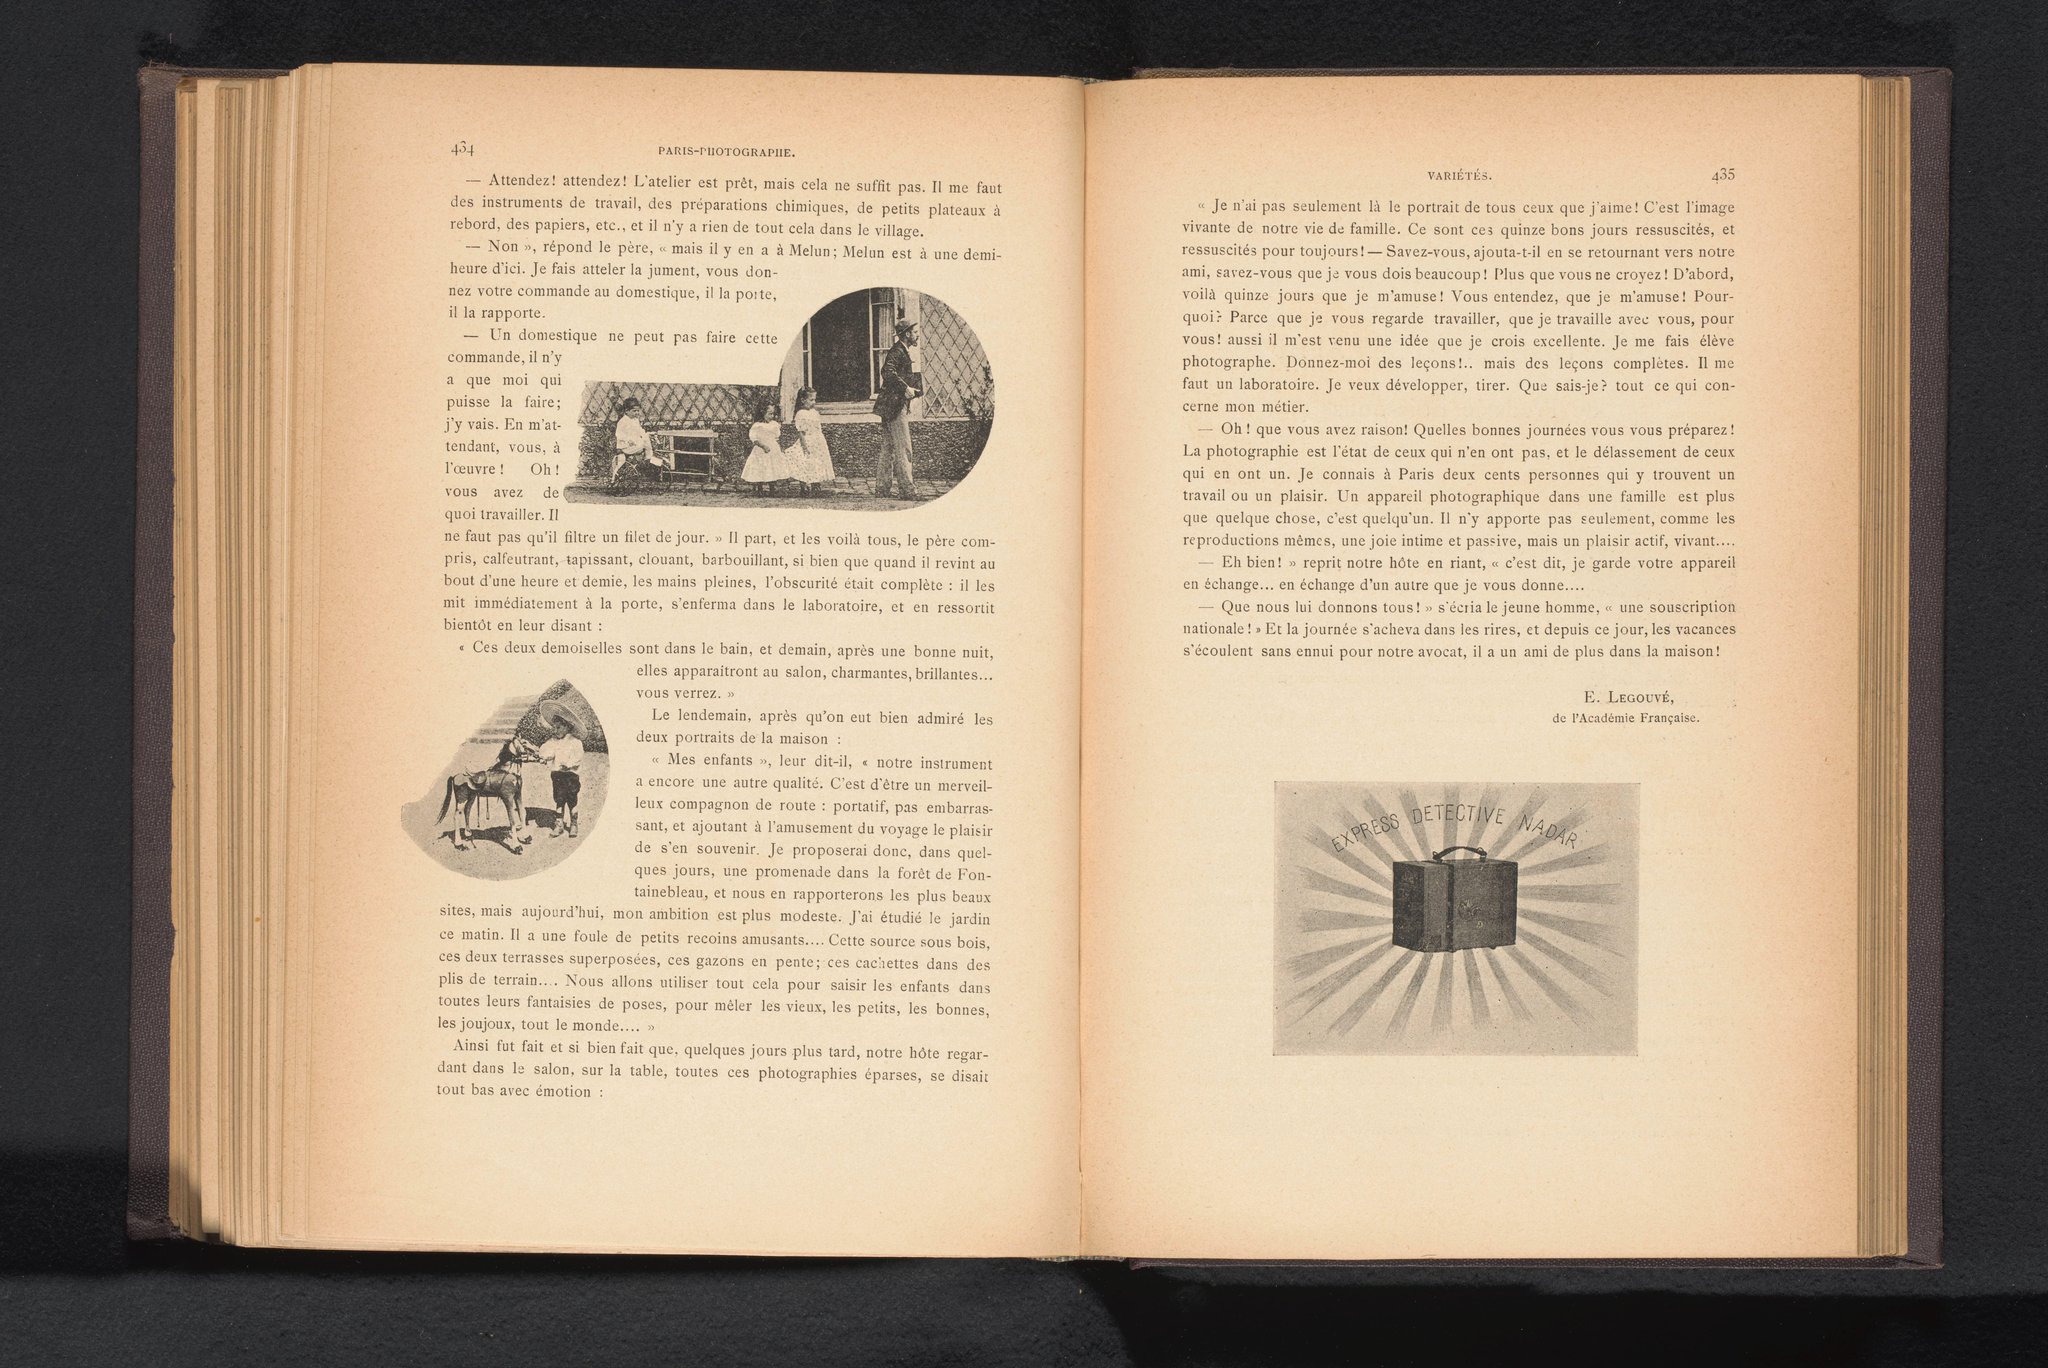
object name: page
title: Koffer met daarboven de tekst Express Detective Nadar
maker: félix nadar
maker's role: ballonvaarder, fotograaf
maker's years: 1820-1910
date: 1883-1893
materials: paper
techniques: autotype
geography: france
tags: trunk, suit-case